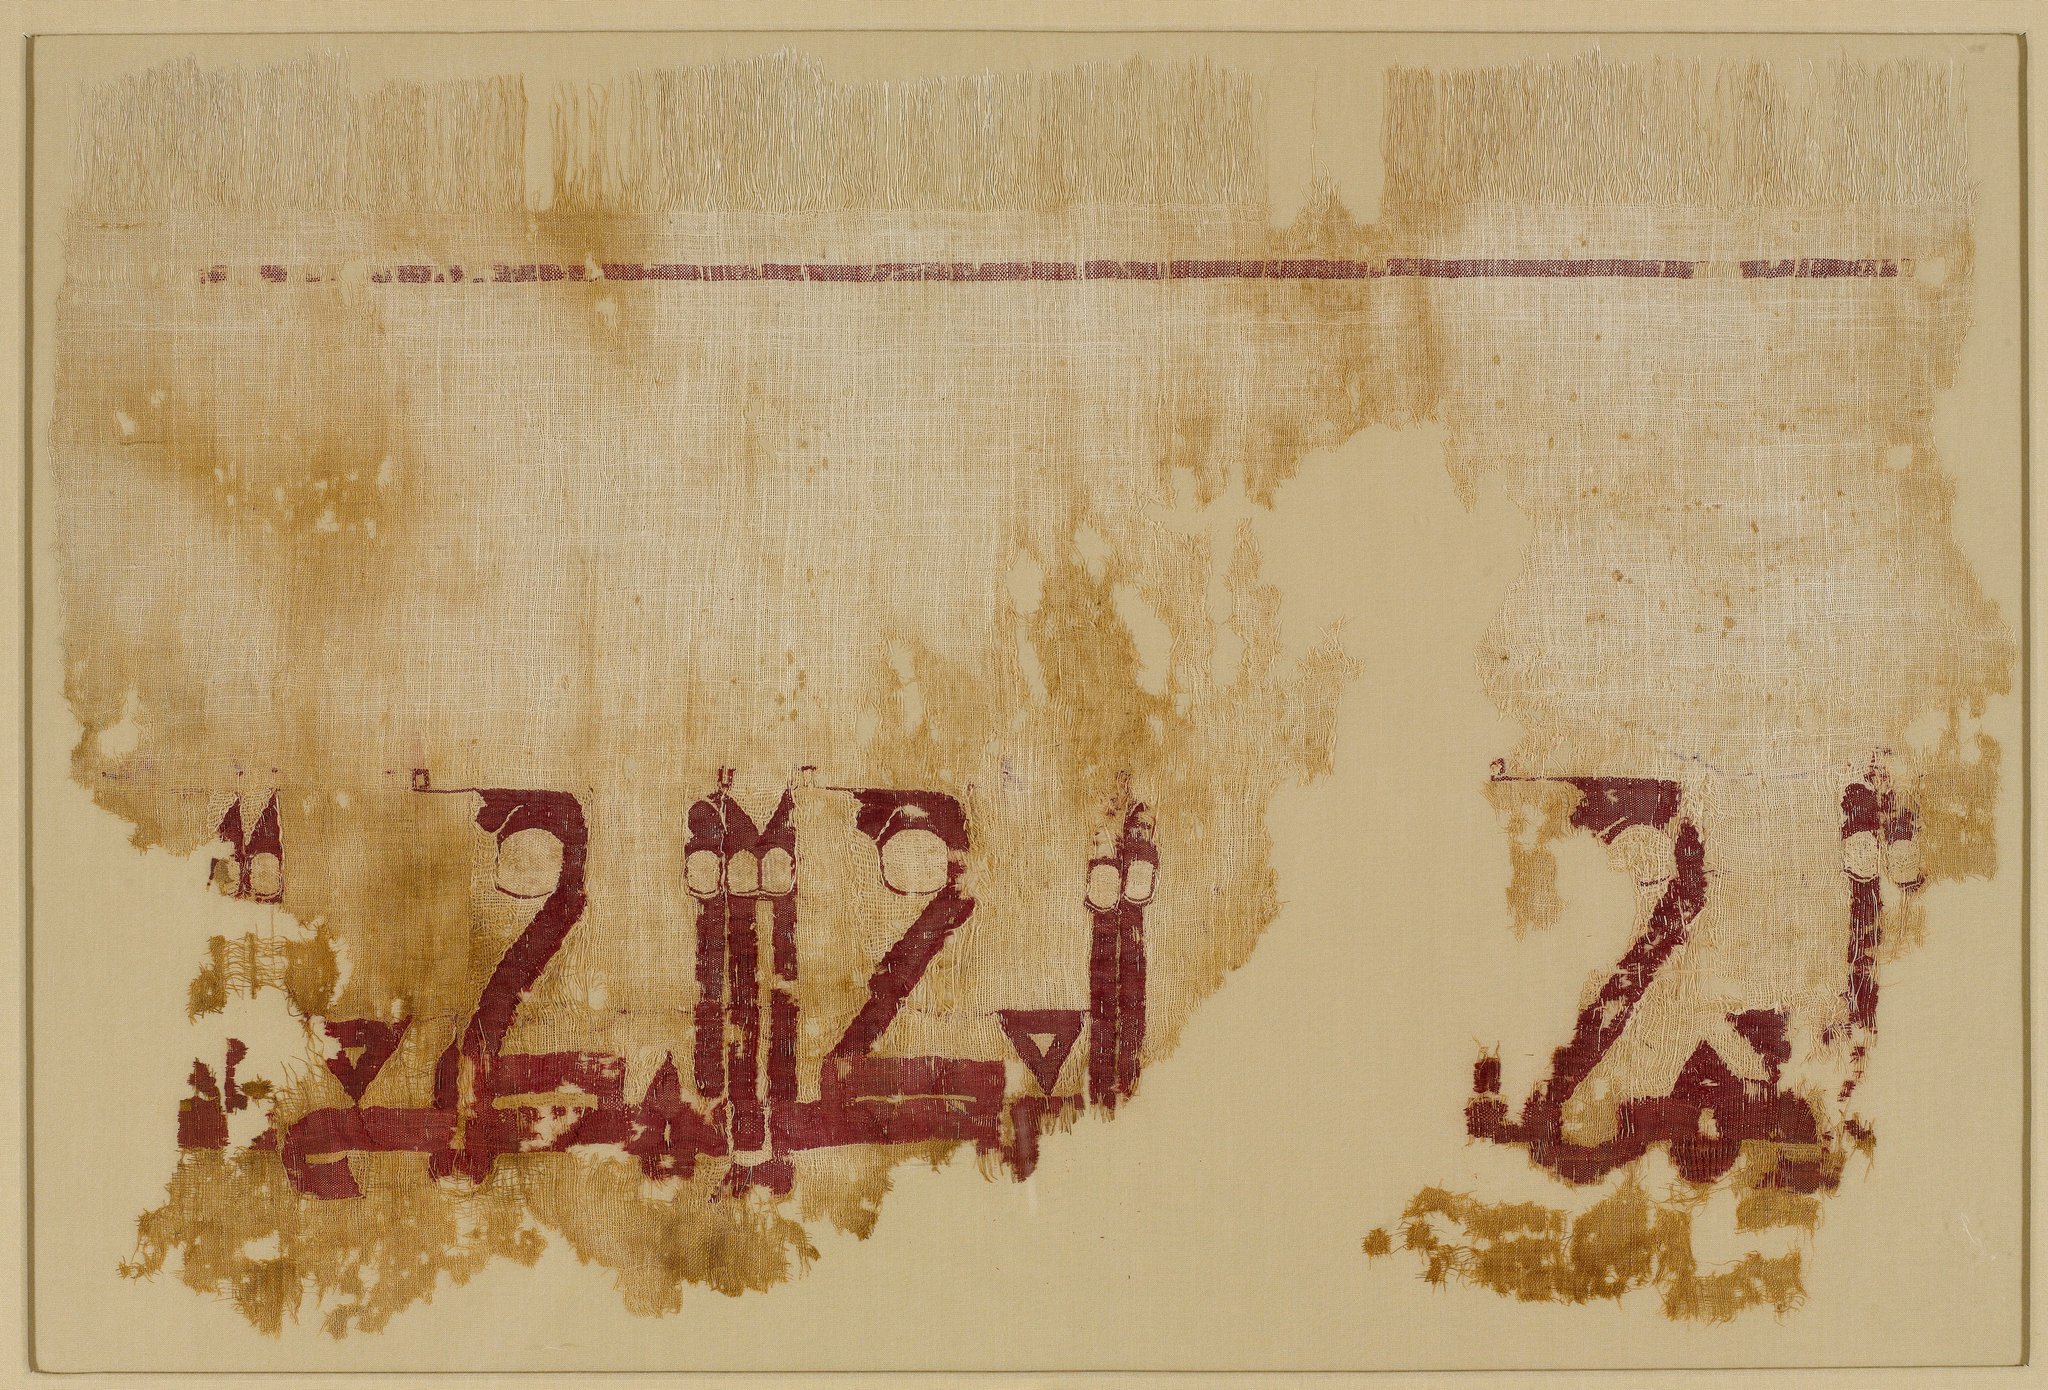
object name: textile fragment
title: Textile with Kufic Inscription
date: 946-974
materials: linen, silk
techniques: weave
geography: egypt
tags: arabic